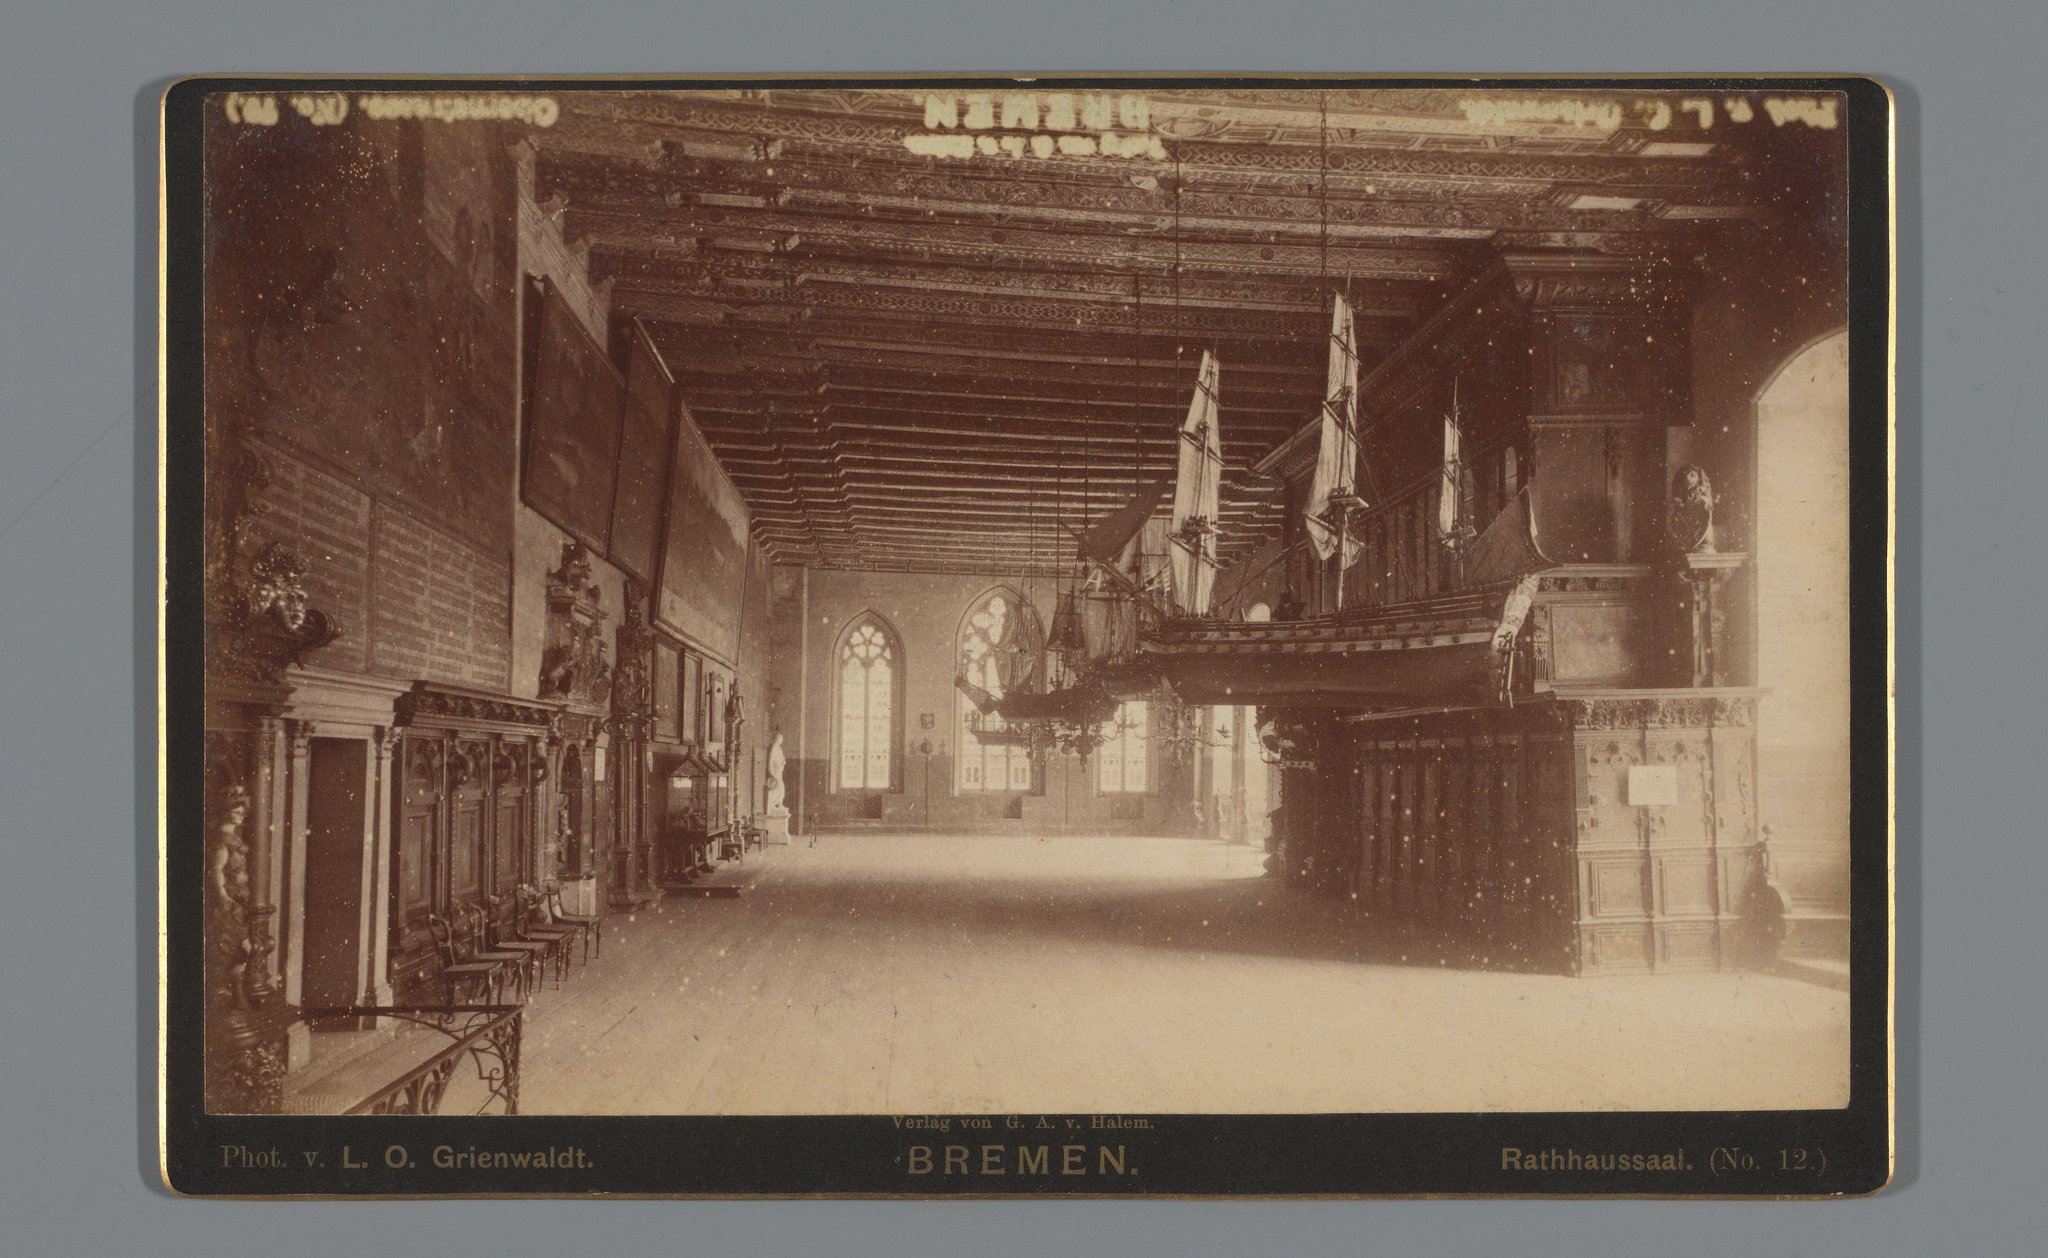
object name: photograph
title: Bremen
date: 1890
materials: cardboard, photographic support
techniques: albumen print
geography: bremen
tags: townhall, other rooms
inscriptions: inscription: ‘L.O. Grienwaldt/ Bremen/ 1890’, inscription: ‘Rathhaussaal. (No. 12.)’